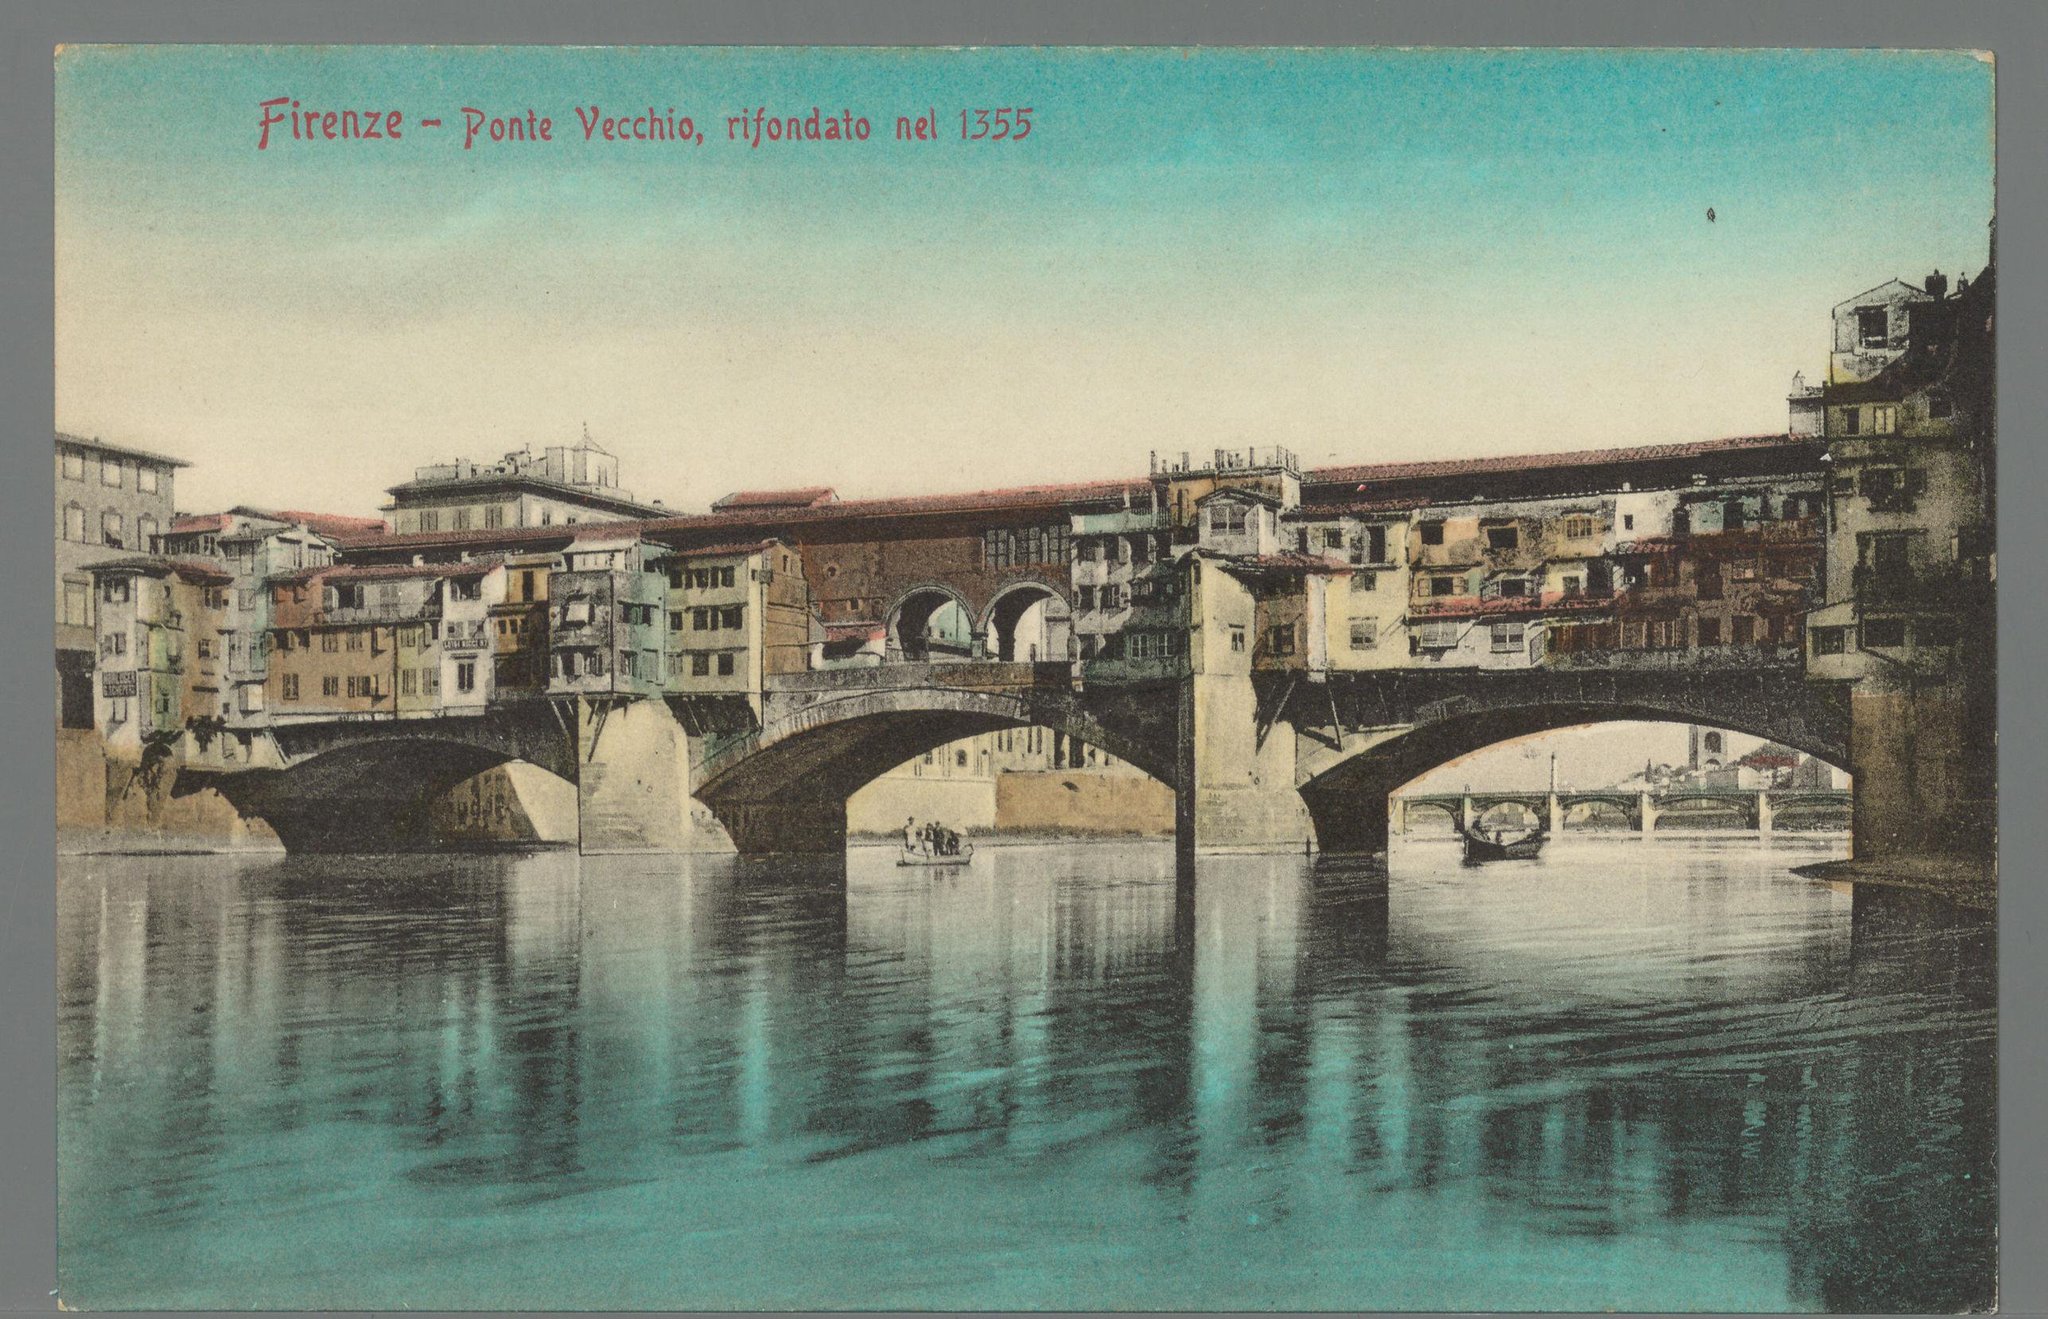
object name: ansichtkaart, prentbriefkaart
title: Firenze. Ponte Vecchio, rifondato nel 1355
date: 1905-1930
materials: cardboard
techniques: photograph, lithograph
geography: dresden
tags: river, bridge, city-view, and landscape with man-made constructions (+ city(-scape) with figures, staffage)